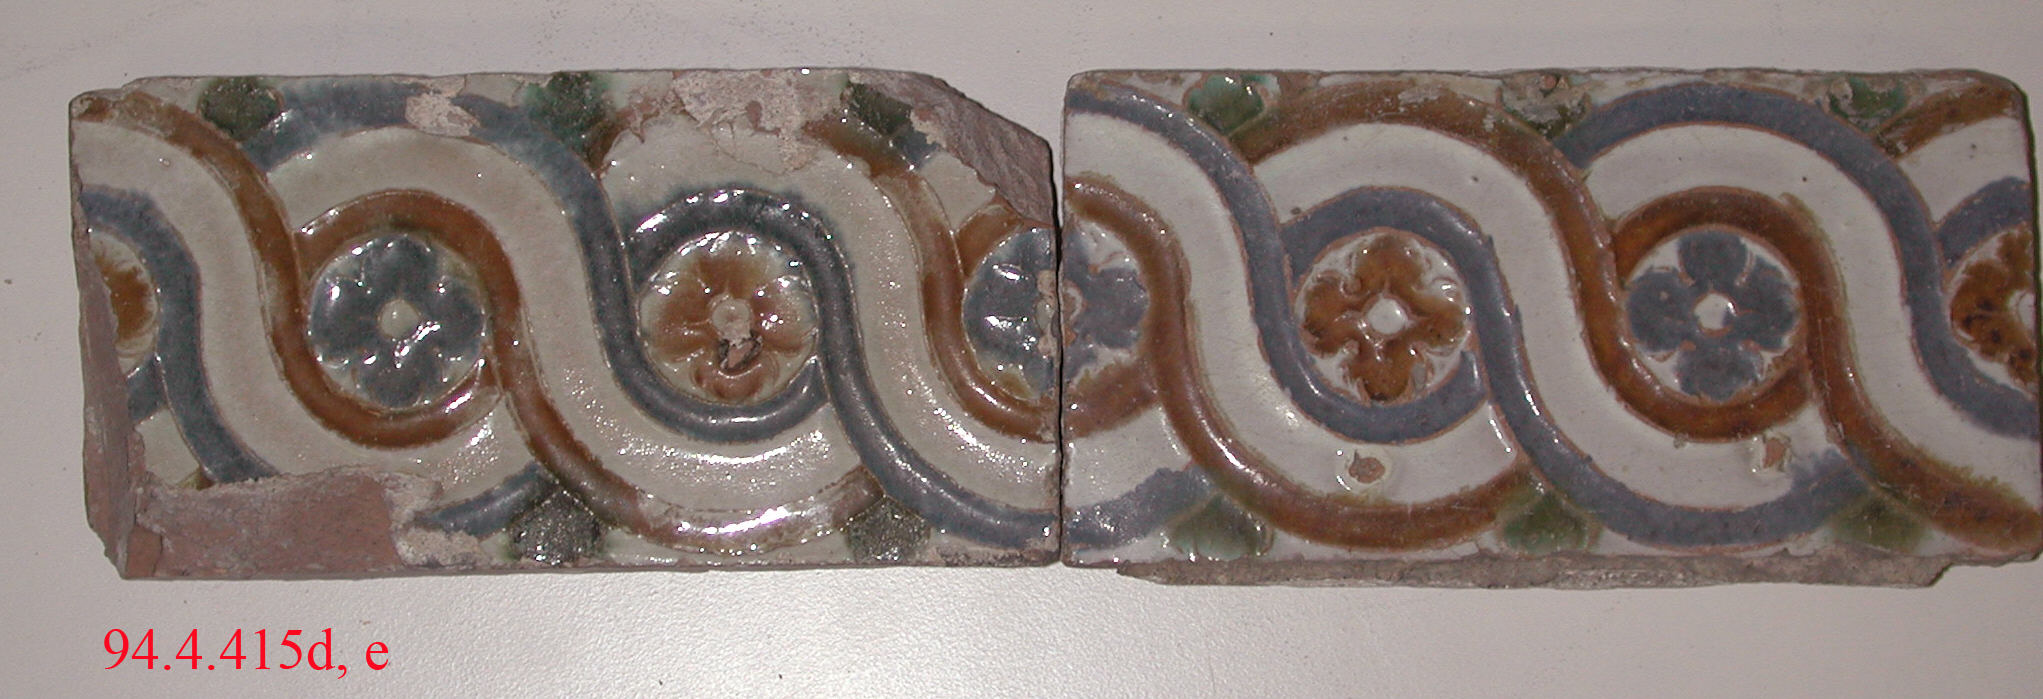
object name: wall tile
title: Wall tiles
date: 1501-1700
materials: earthenware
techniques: glazing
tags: flowers